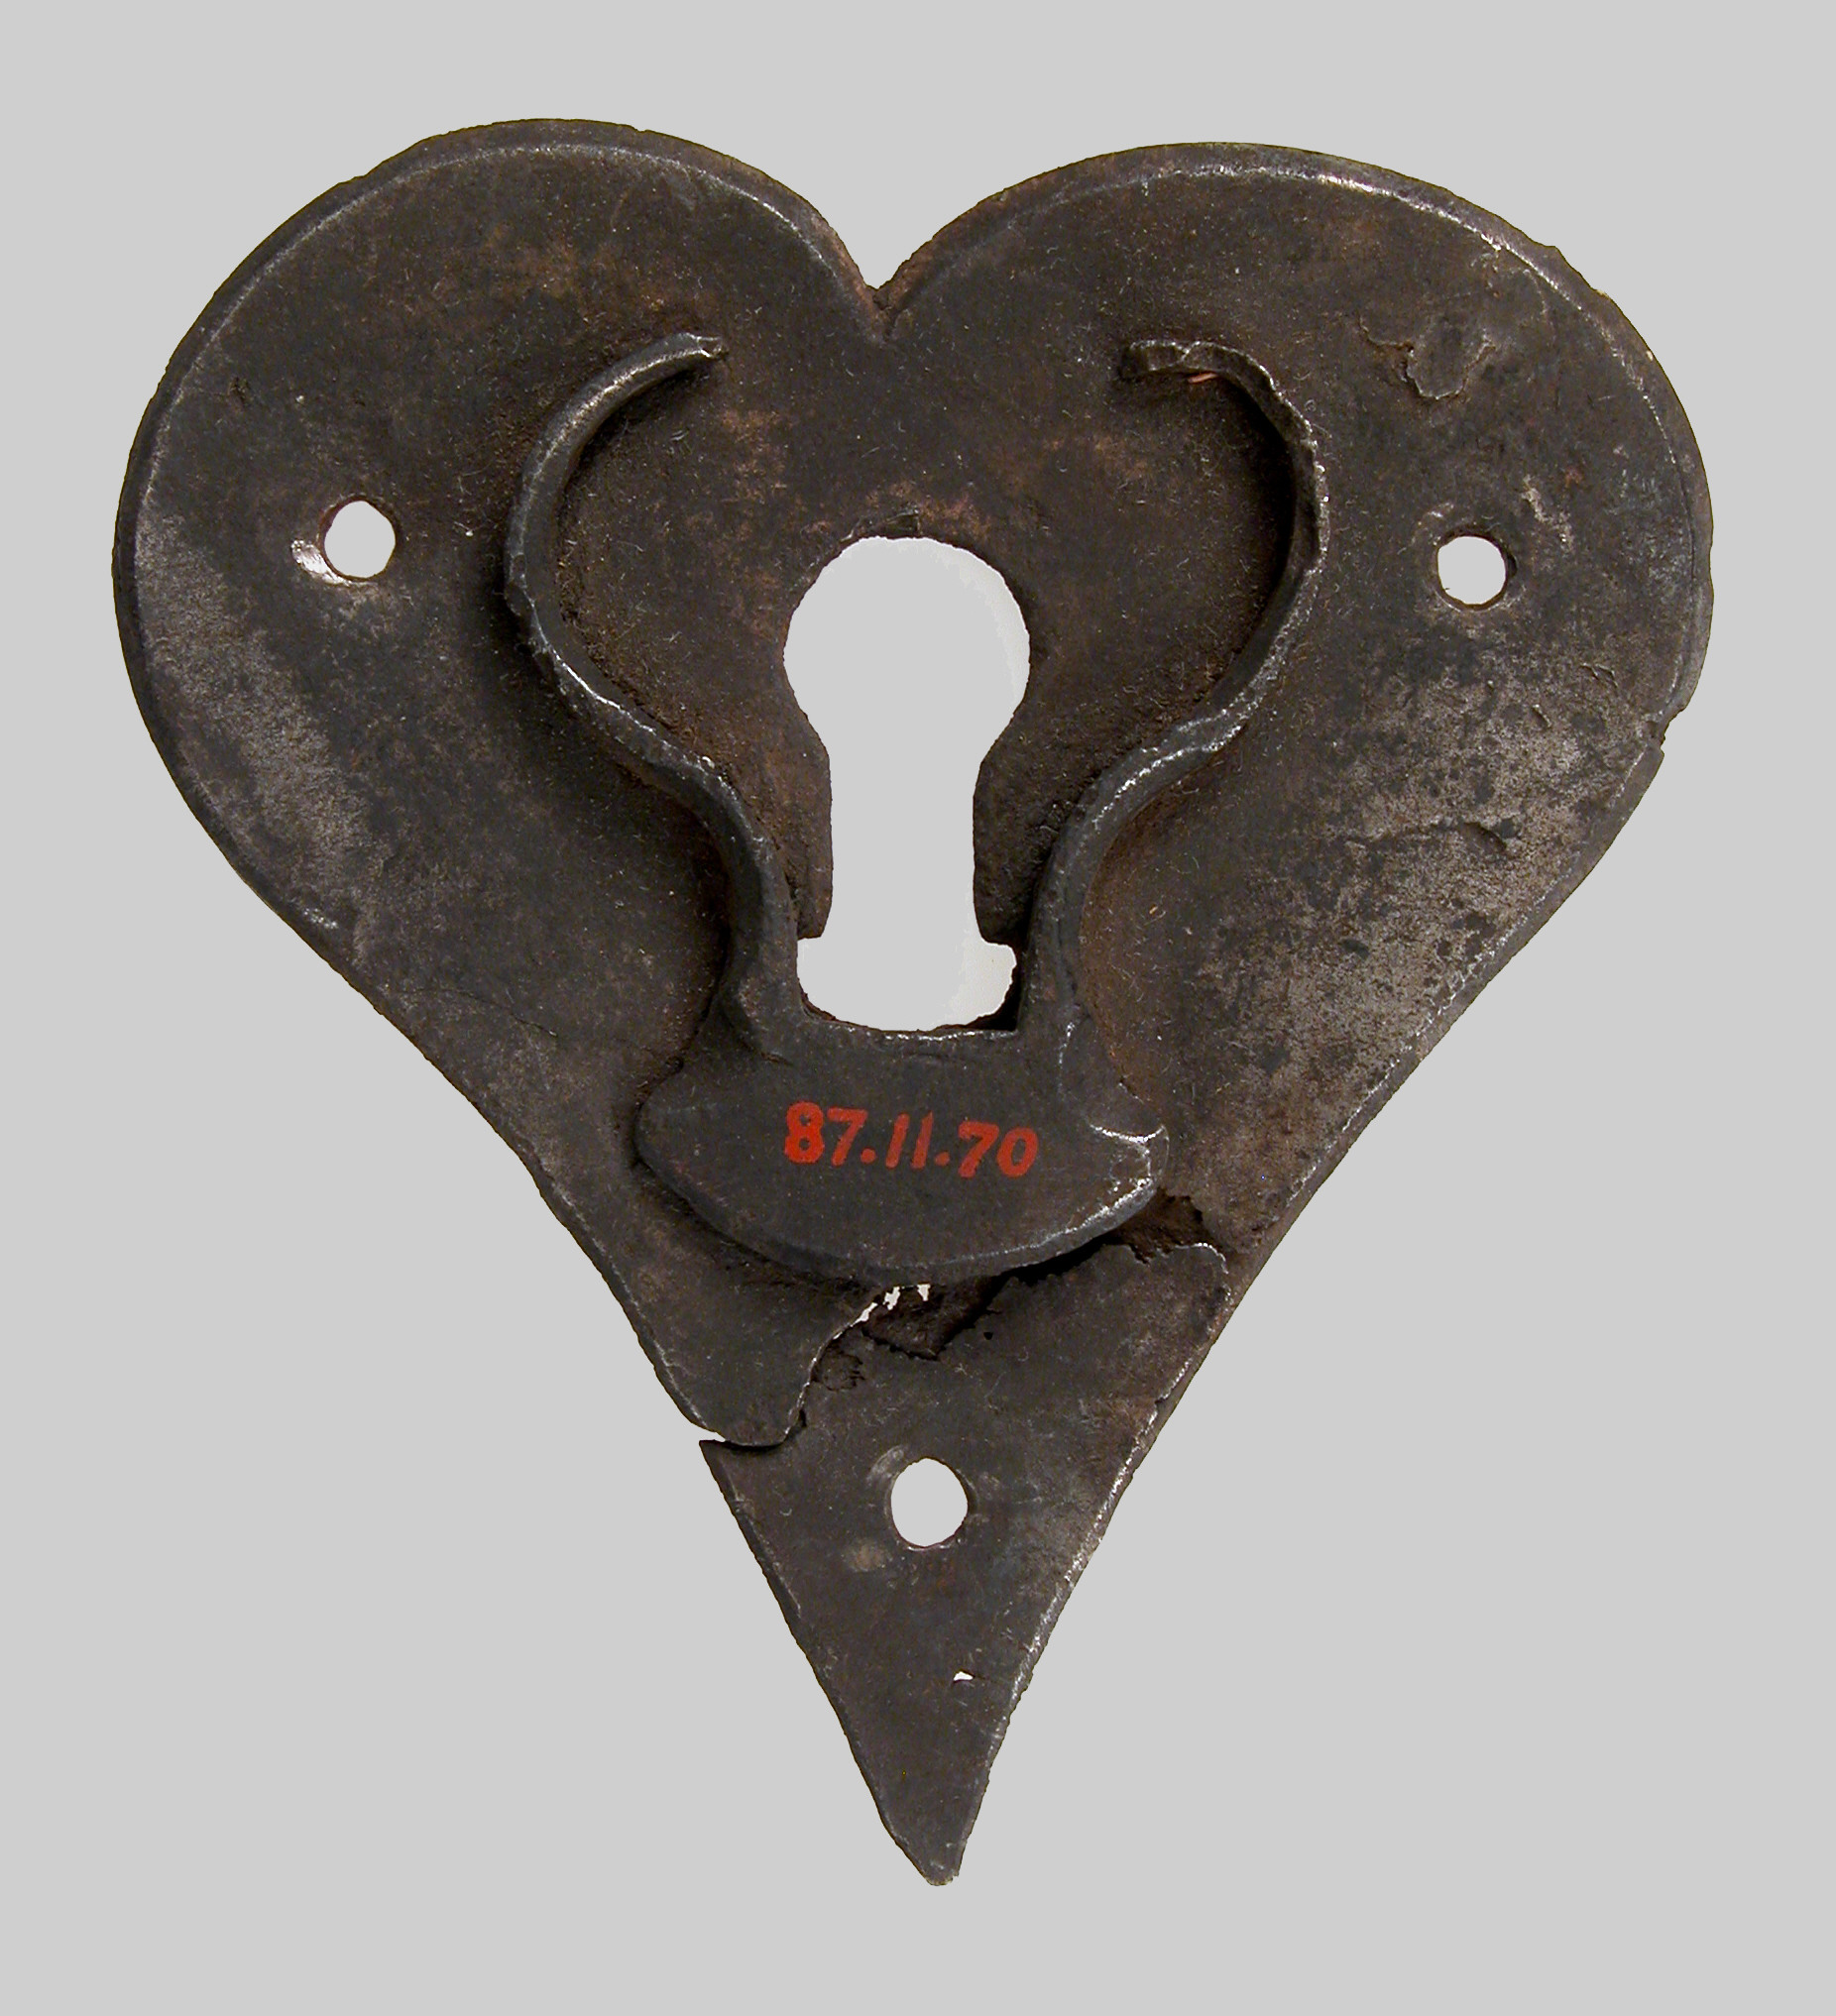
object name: escutcheon plate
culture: german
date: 1401-1433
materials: iron